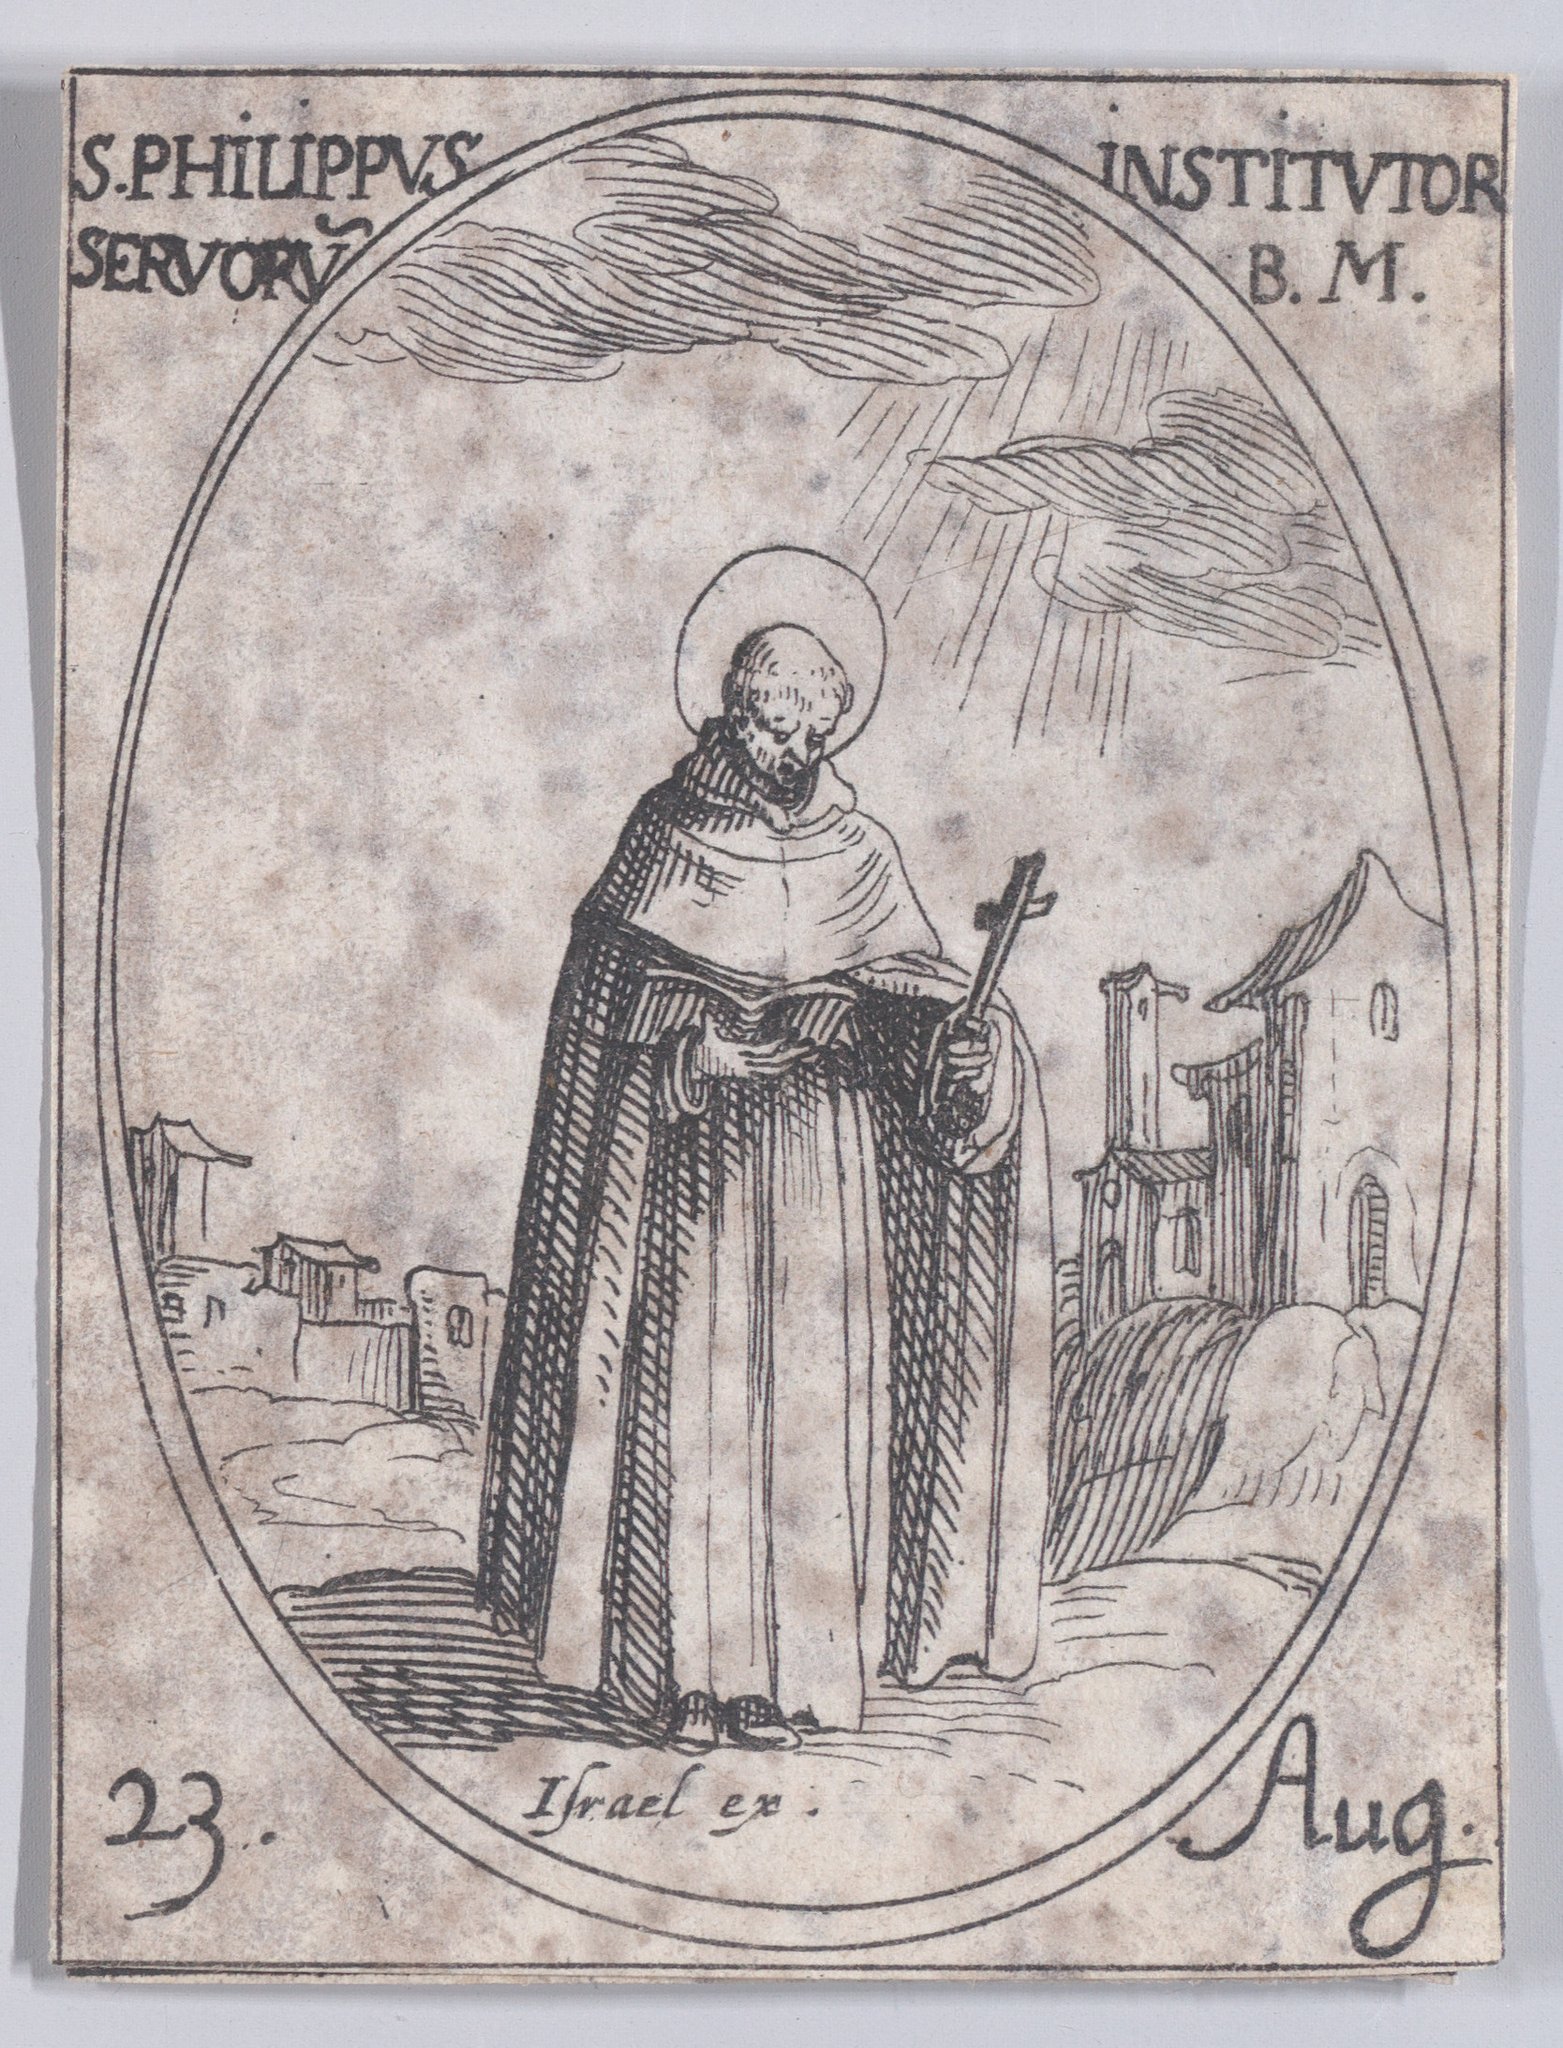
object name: print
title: S. Philippe, Fondateur de l'Ordre des Servites (St. Philip Benizi, Founder of the Servite Order), August 23rd, from "Les Images De Tous Les Saincts et Saintes de L'Année" (Images of All of the Saints and Religious Events of the Year)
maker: jacques callot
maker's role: artist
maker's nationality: french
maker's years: 1592-1635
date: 1636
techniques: etching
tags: men,saints